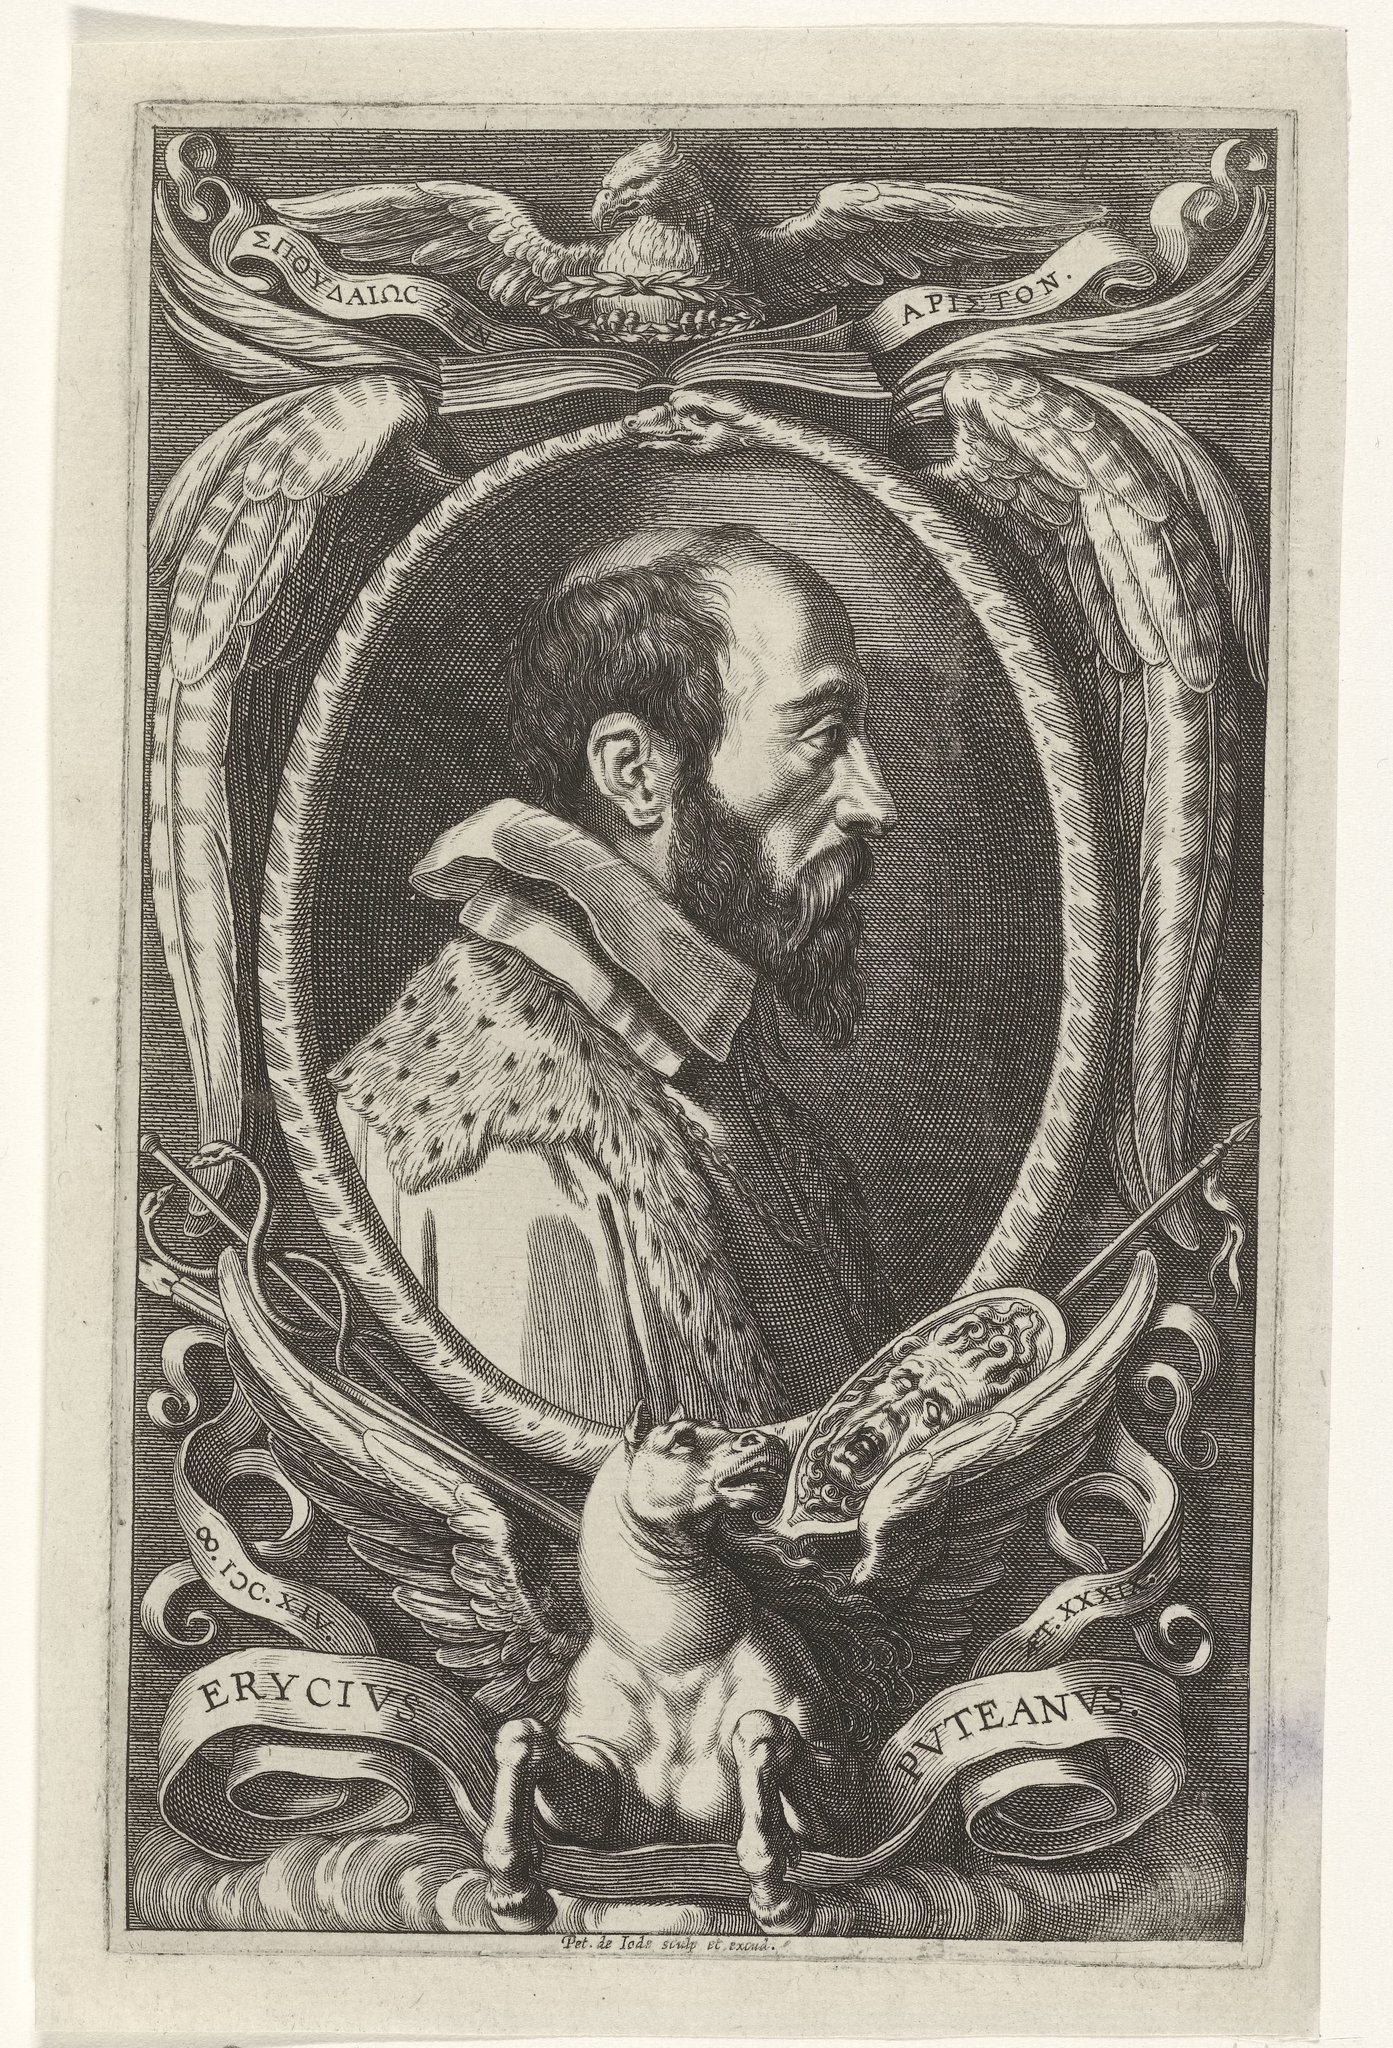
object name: print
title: Portret van Erycius Puteanus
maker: pieter de jode (i)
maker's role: draughtsman, print maker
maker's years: 1570-1634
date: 1590-1632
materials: paper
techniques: engraving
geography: antwerp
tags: erycius puteanus, pegasus, the winged horse, predatory birds: eagle, caduceus (staff with two snakes, attribute of mercury), attributes of medusa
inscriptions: collector's mark: Lugt 2228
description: Busteportret van Erycius Puteanus. Het portret is gevat in een omlijsting met vleugels, die wordt bekroond door een opengeslagen boek, een lauwerkrans, een adelaar en een banderol met zijn devies in het Grieks. Onder de omlijsting een schild met het hoofd van Medusa, de caduceus van Mercurius, Pegasus en een banderol met de naam en geboorte- en sterfdata van de geportretteerde.